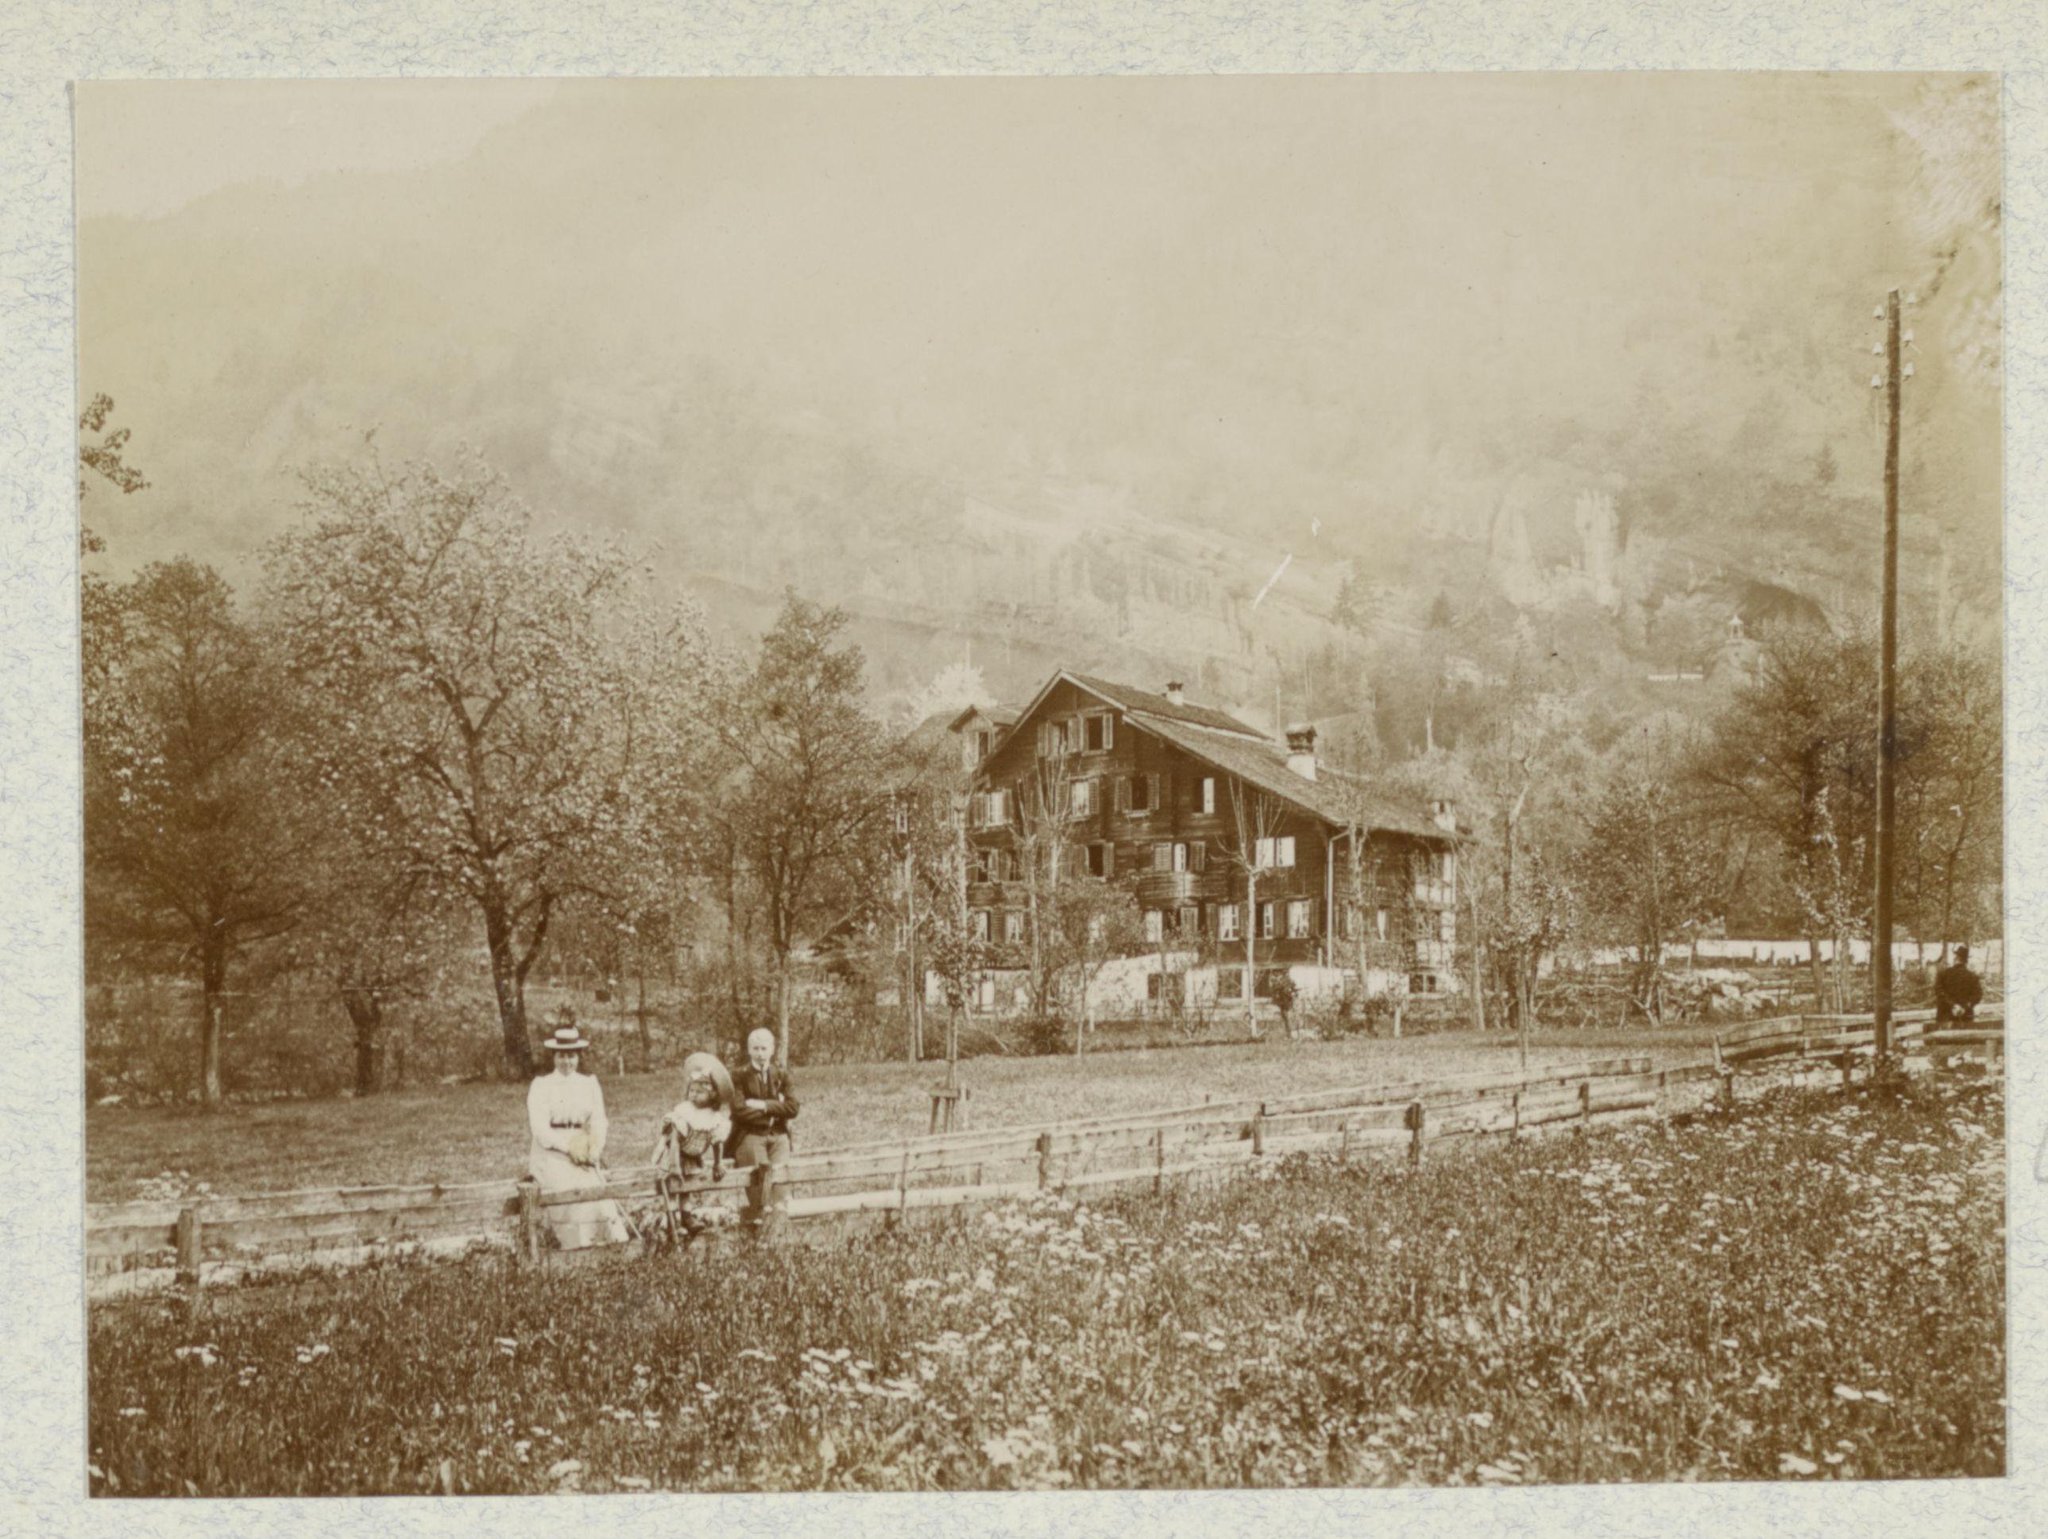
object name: photograph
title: Vakantie in Zwitserland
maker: andries augustus boom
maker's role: amateurfotograaf, handelaar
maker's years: 1878-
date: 1805-1899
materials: photographic support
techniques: photography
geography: switzerland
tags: andries augustus boom, switzerland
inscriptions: date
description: Vakantie in Zwitserland, Vitznau. Onderdeel van het fotoalbum van de familie Boom-Gonggrijp in Suriname en Curaçao.